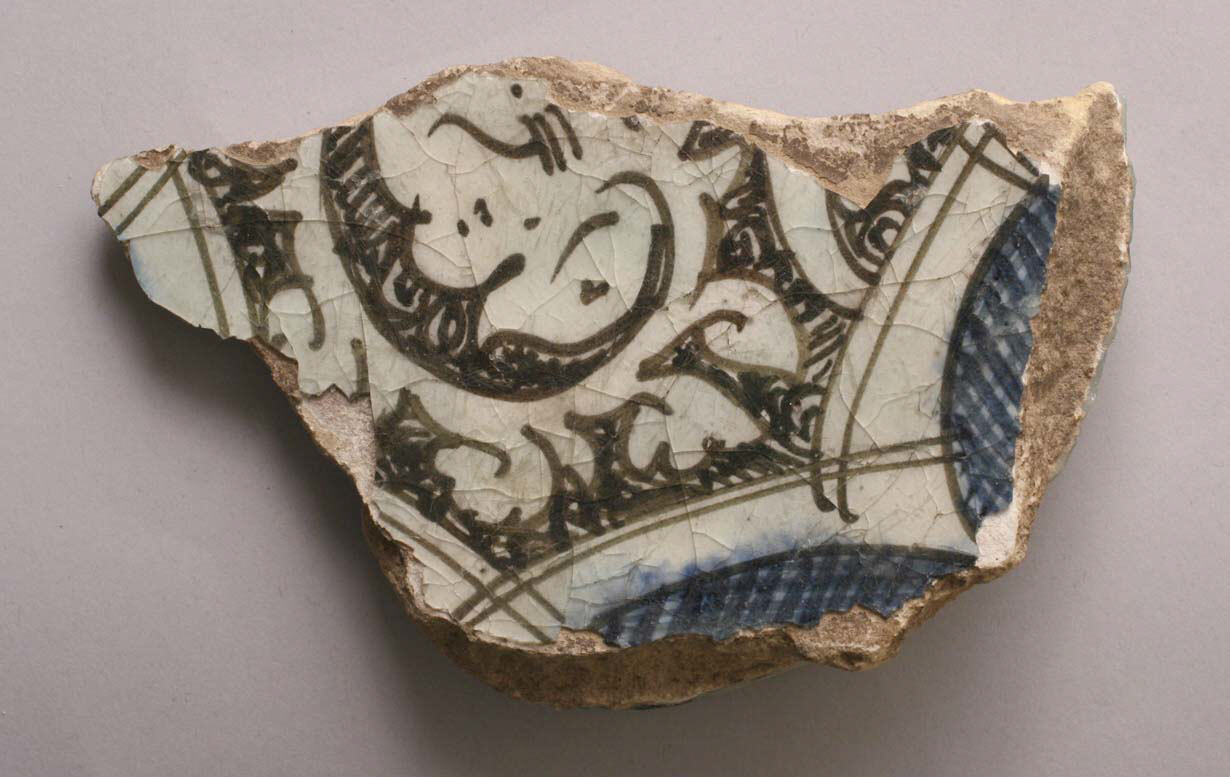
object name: fragment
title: Ceramic Fragment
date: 1301-1400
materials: glaze, stonepaste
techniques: painting, polychrome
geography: egypt or syria